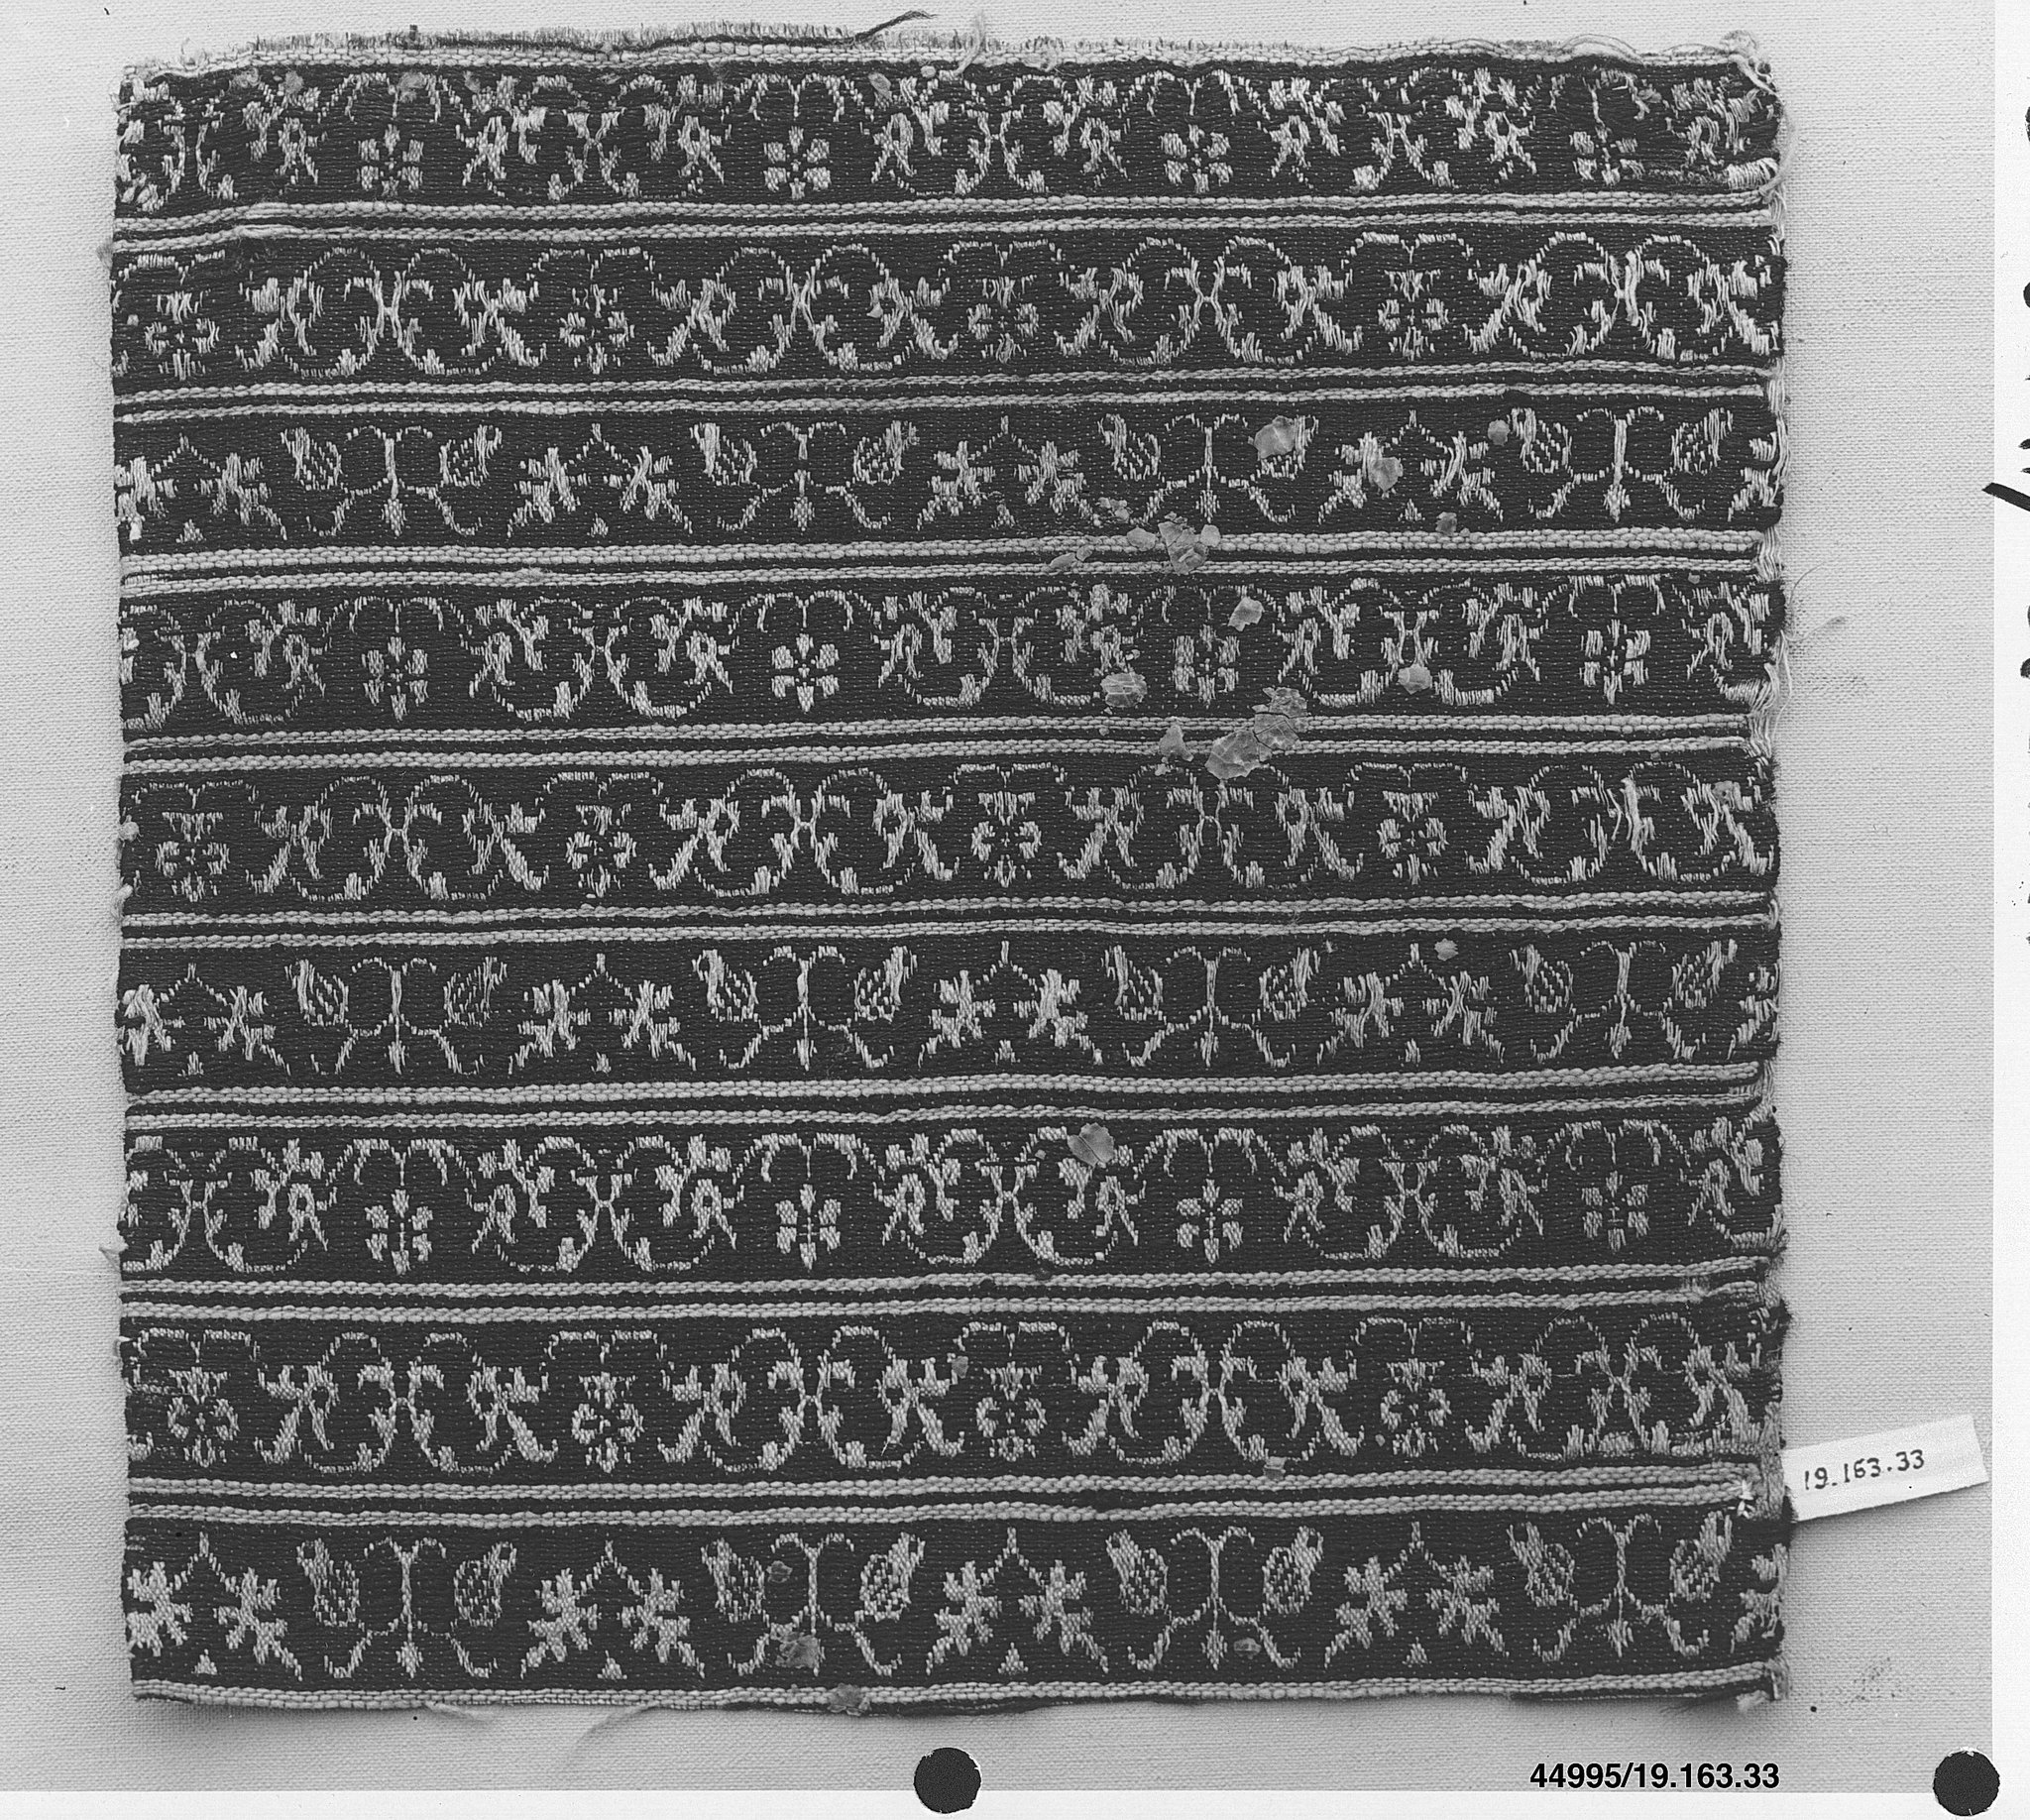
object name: fragment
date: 1501-1600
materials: cotton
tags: flowers,leaves